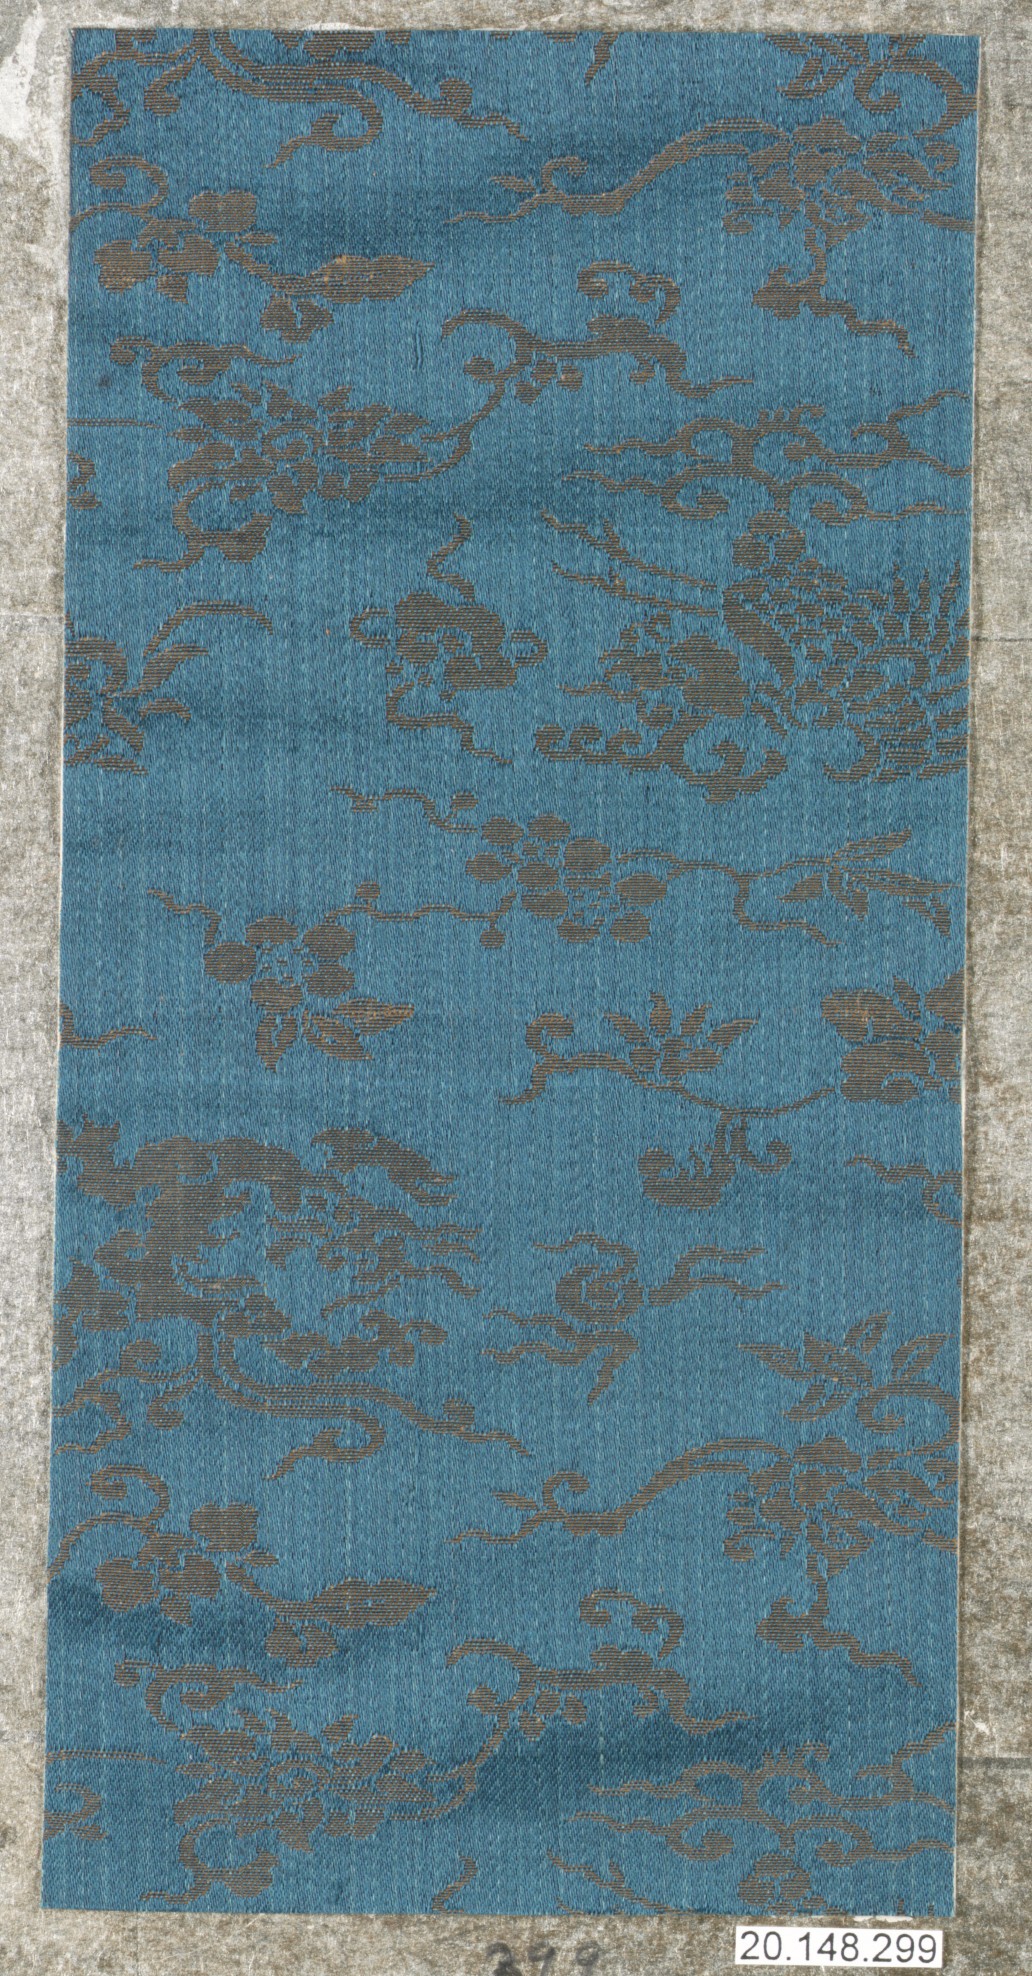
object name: piece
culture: japanese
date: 1701-1800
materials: silk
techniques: compound weave